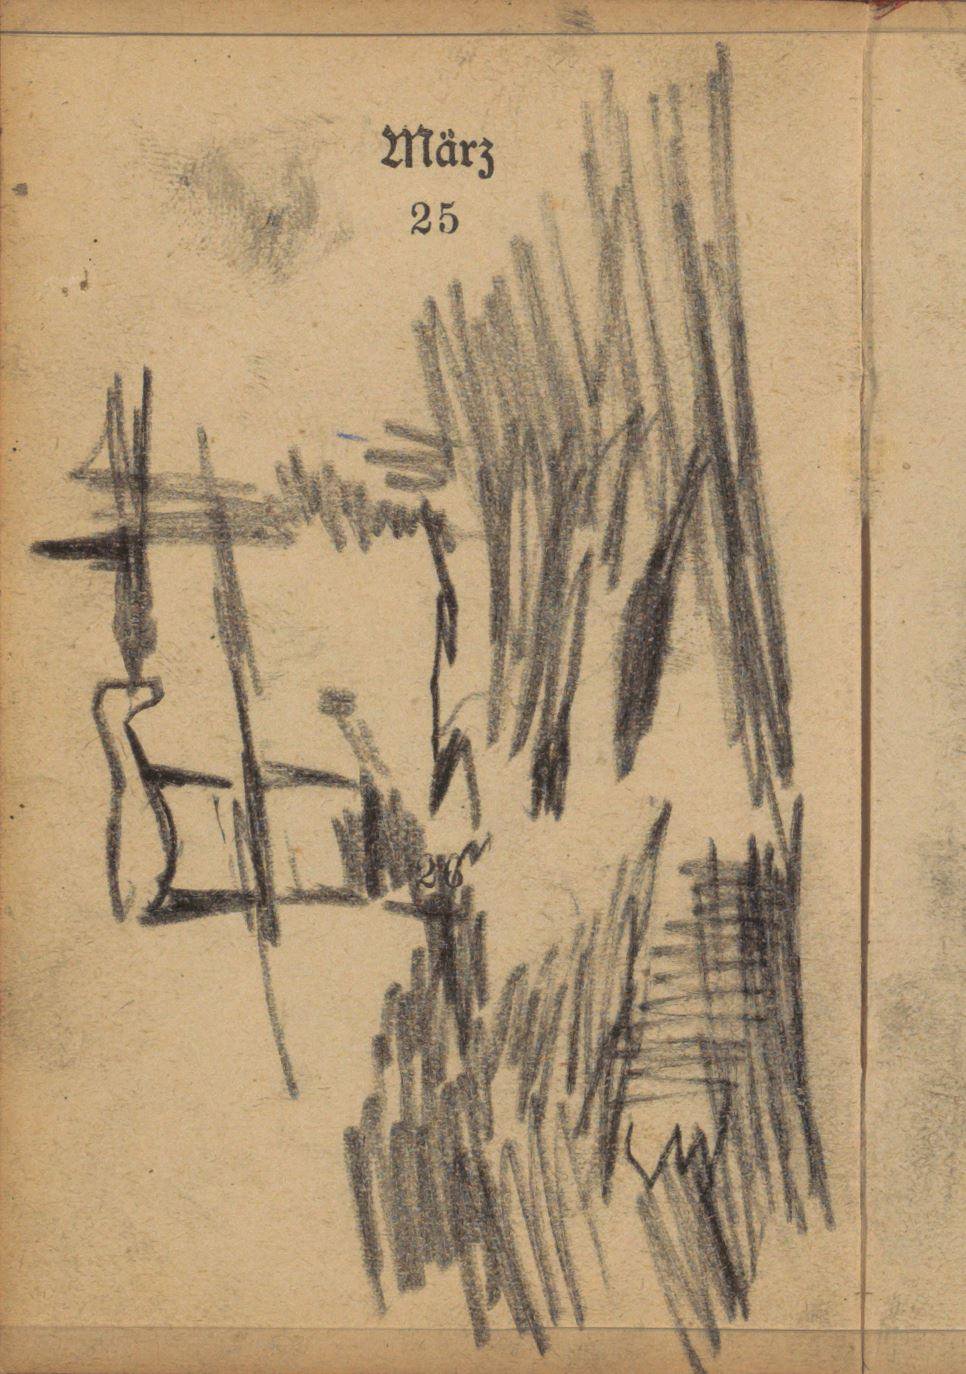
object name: sketchbook leaf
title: Studie, mogelijk van een dier aan de waterkant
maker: george hendrik breitner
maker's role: draughtsman, painter, print maker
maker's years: 1857-1923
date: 1893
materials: chalk, paper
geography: amsterdam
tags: animals, landscapes with waters, waterscapes, seascapes (in the temperate zone)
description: Pagina 47 uit een als schetsboek gebruikte agenda met 80 bladen.